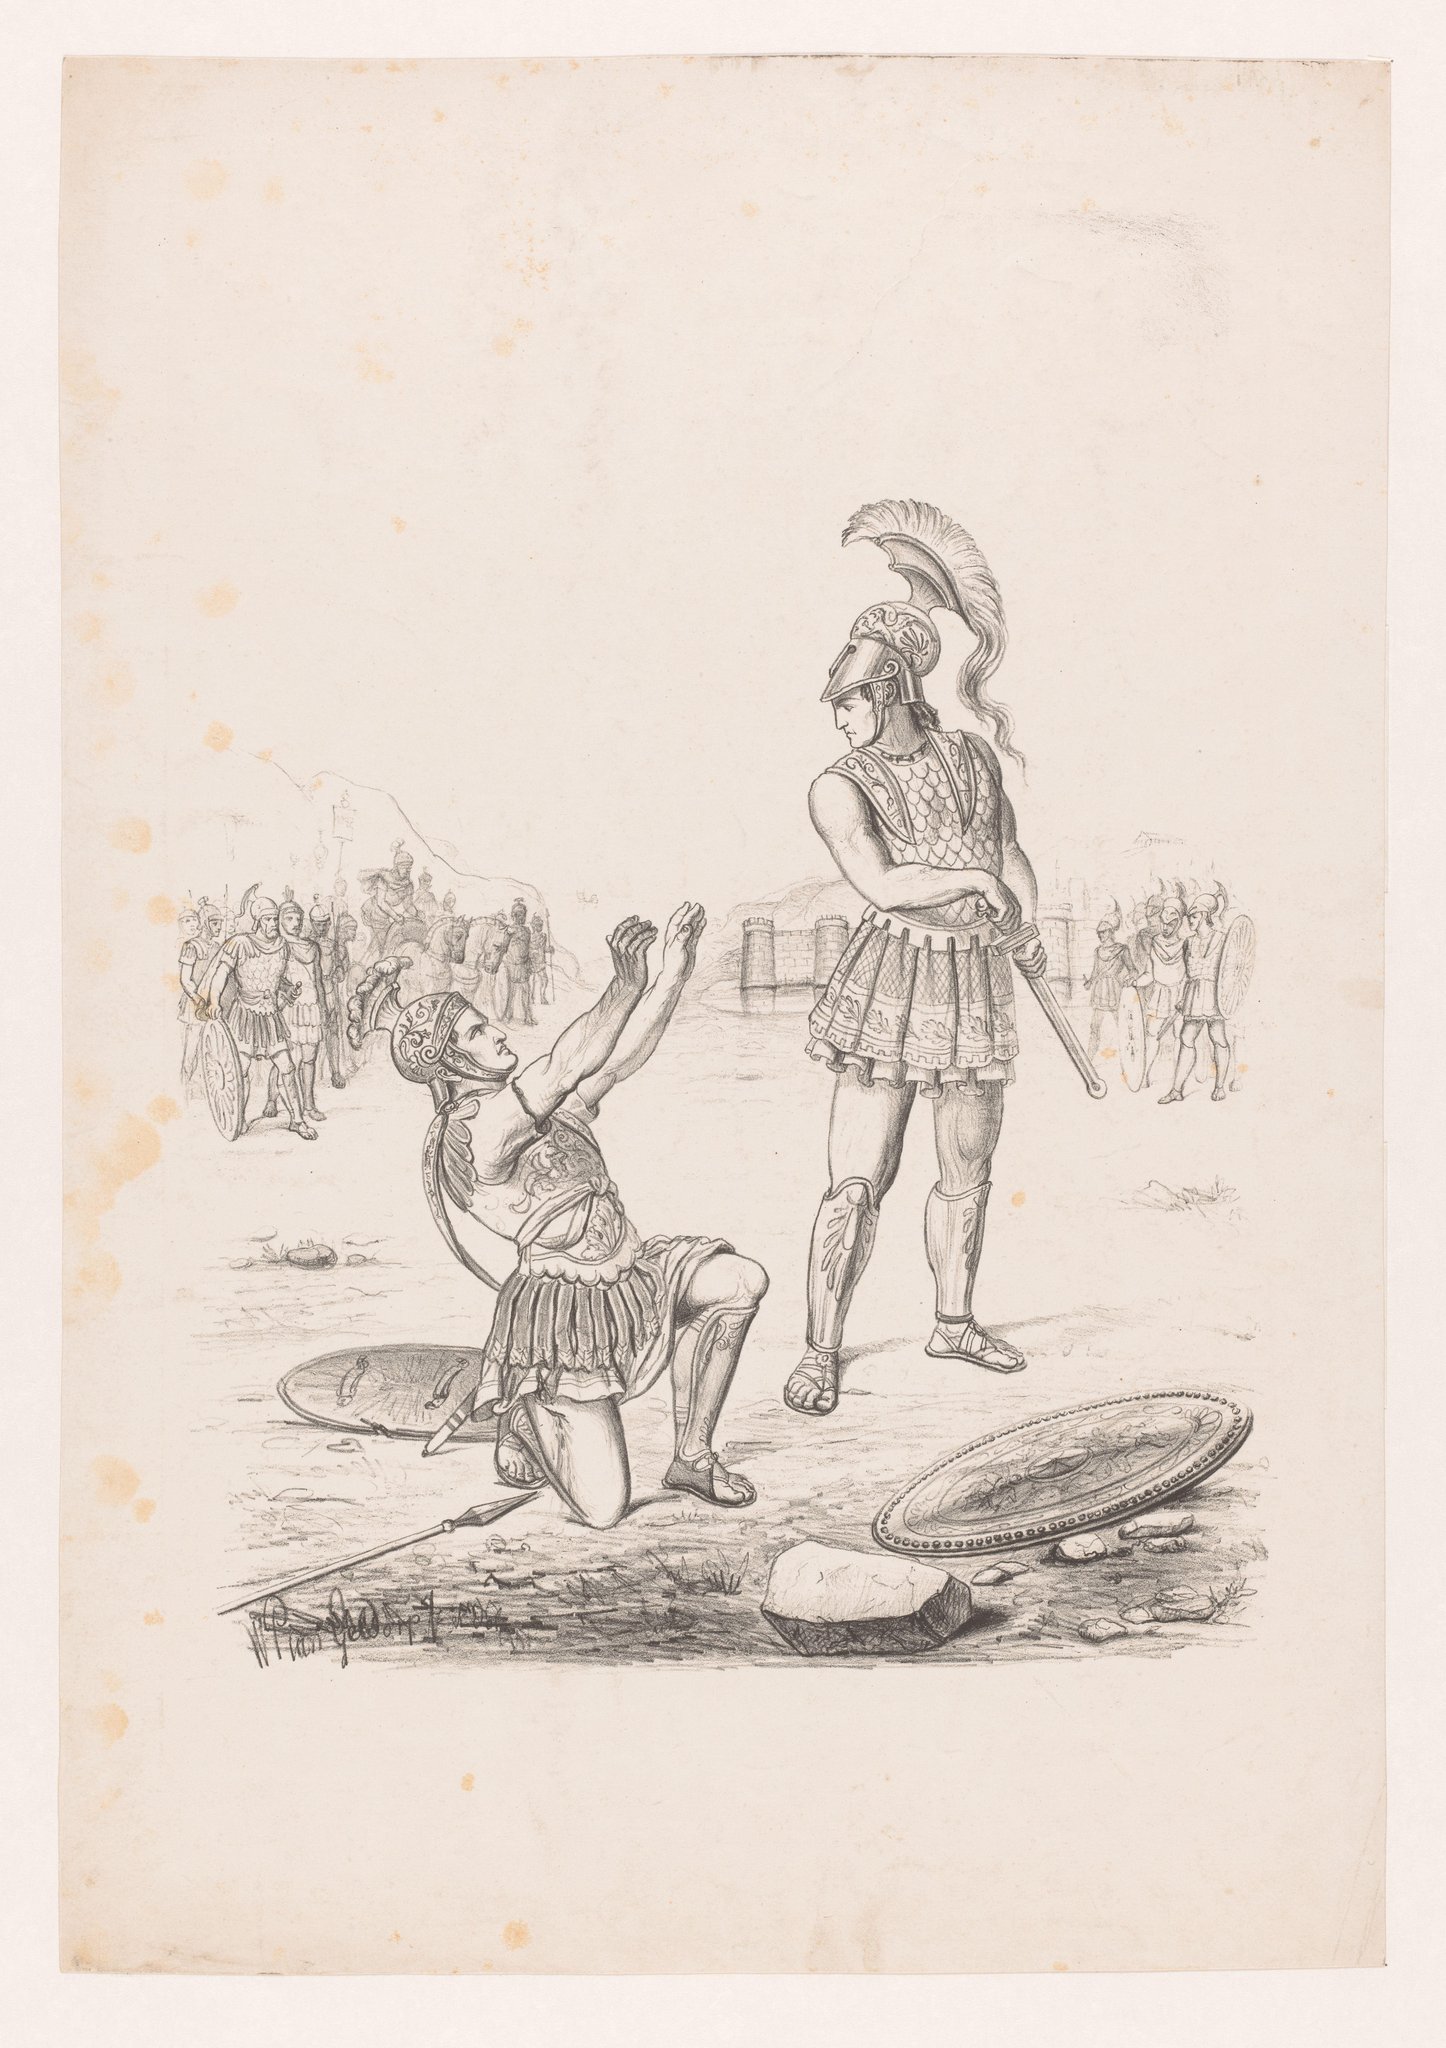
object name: print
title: Turnus door Aeneas overwonnen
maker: wilhelmus petrus van geldorp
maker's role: print maker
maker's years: 1832-1900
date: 1871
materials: paper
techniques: lithograph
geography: rotterdam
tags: death of turnus, hand-to-hand fighting (~ battle)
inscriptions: collector's mark: Lugt 2228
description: Deze prent is afkomstig uit het Kunst-Album door W. P. van Geldorp, achtste aflevering 1871.